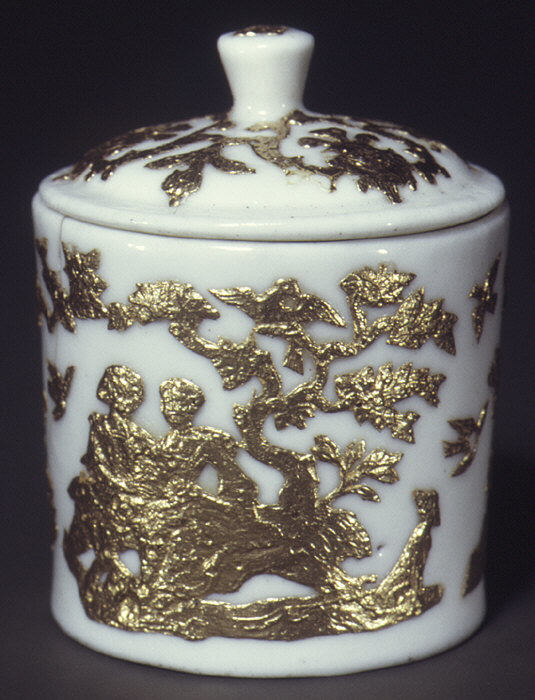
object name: toilet jar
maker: saint-cloud factory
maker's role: factory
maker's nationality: french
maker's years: 1693-1766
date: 1701-1800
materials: soft paste porcelain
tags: trees